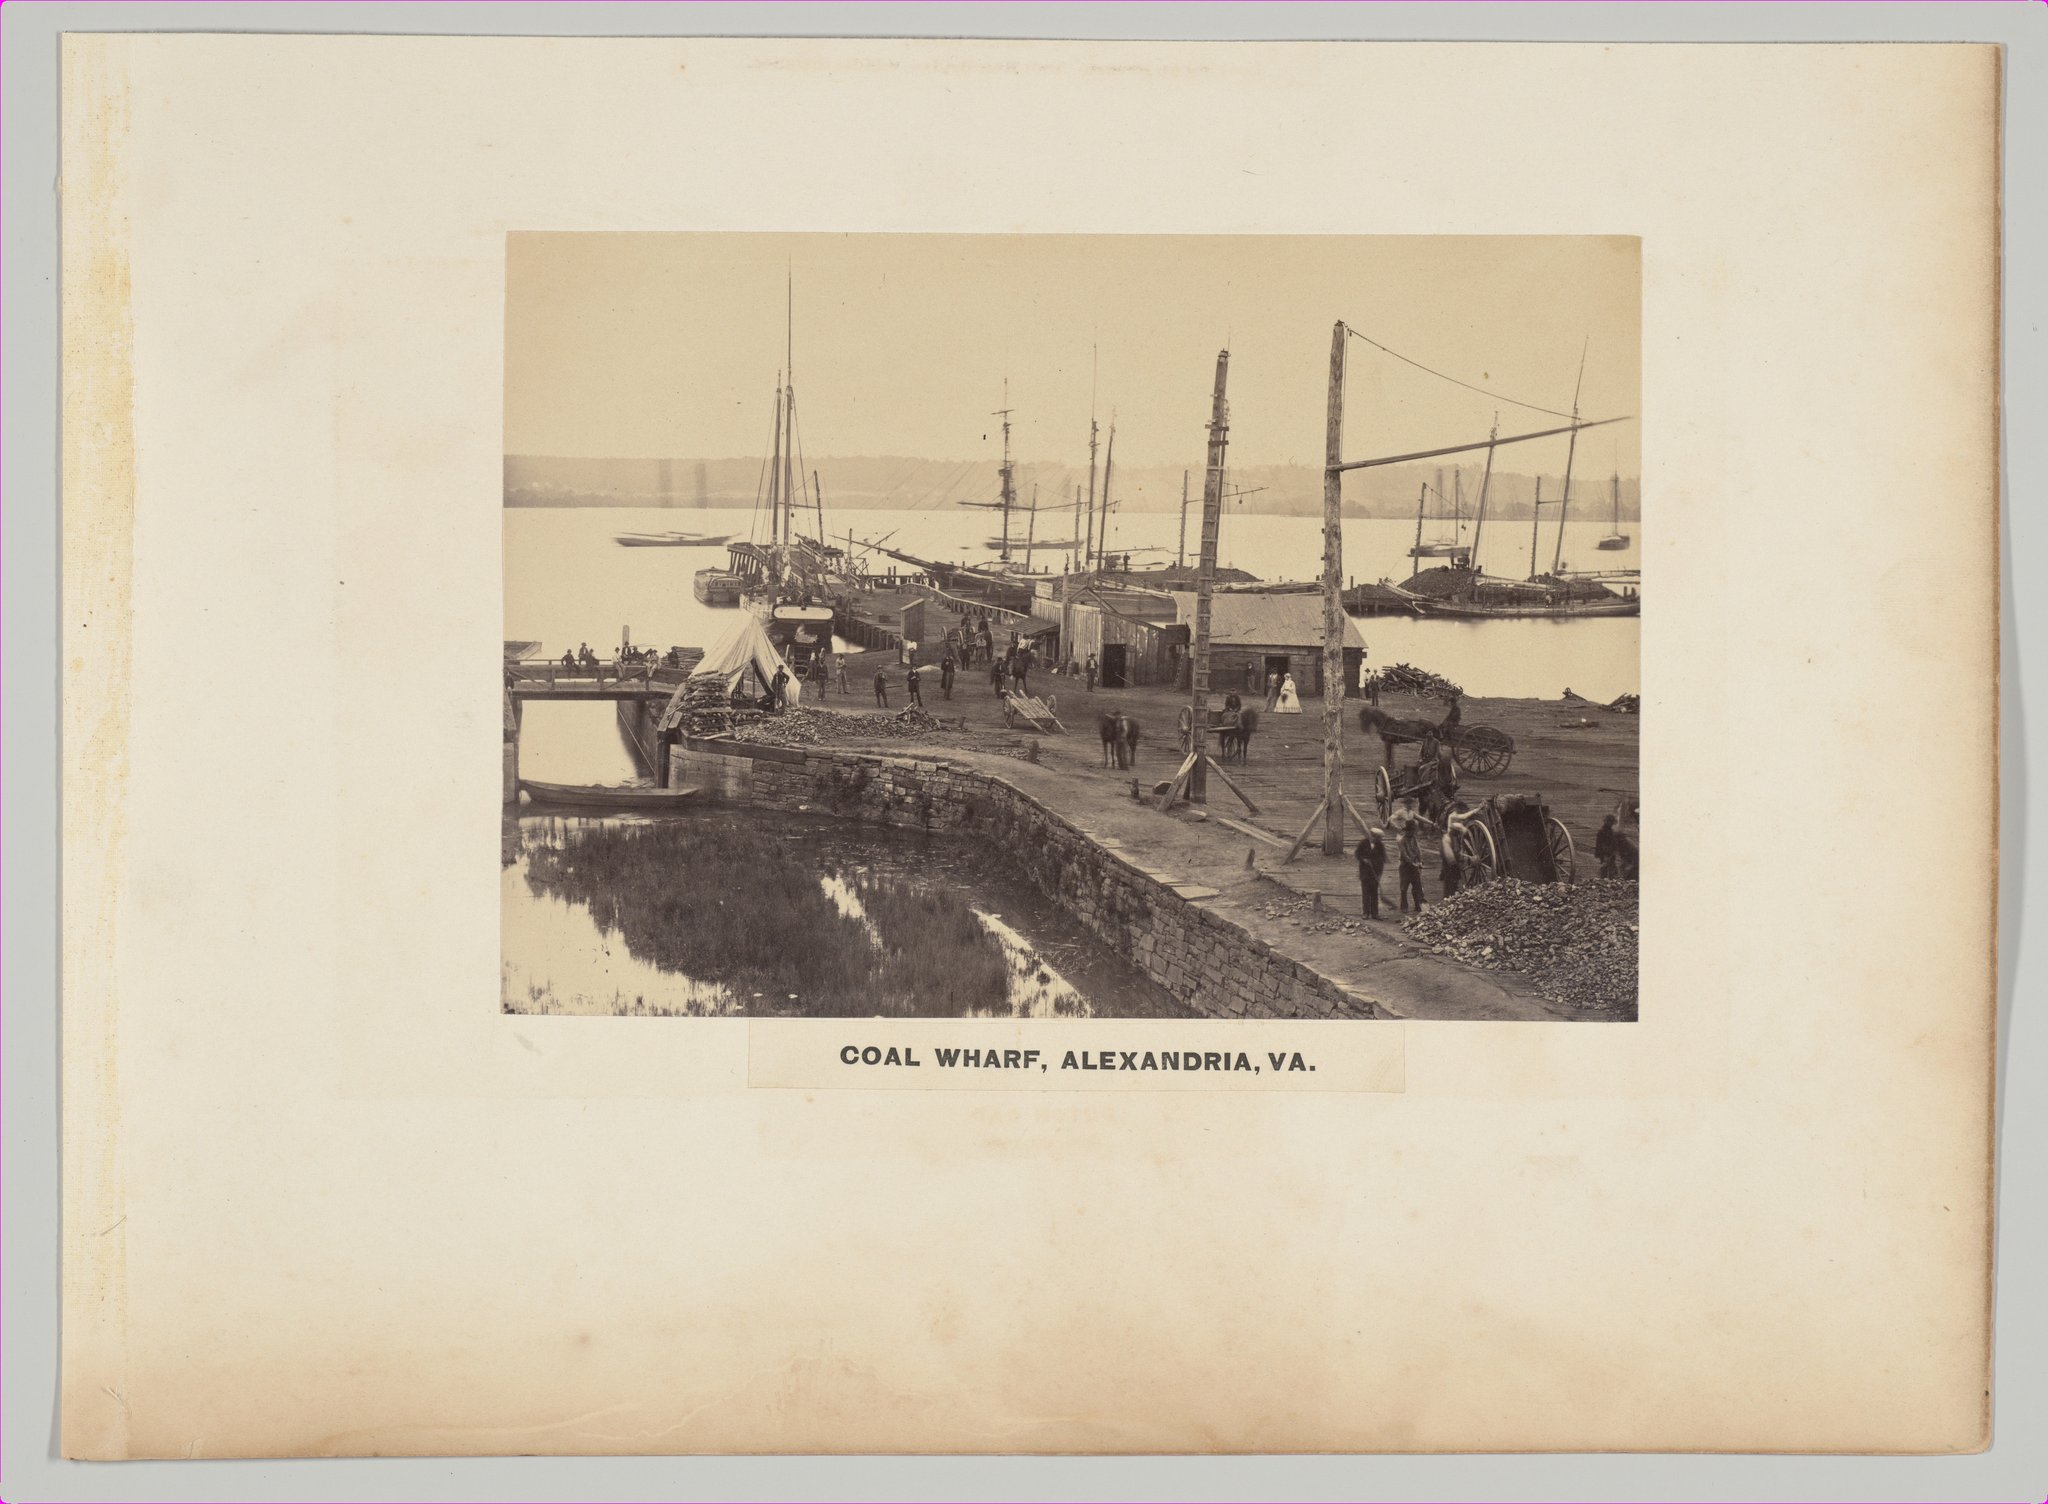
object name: photograph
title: Coal Wharf, Alexandria, Virginia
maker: andrew joseph russell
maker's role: artist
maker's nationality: american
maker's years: 1830-1902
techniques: albumen silver print, glass negative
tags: american civil war